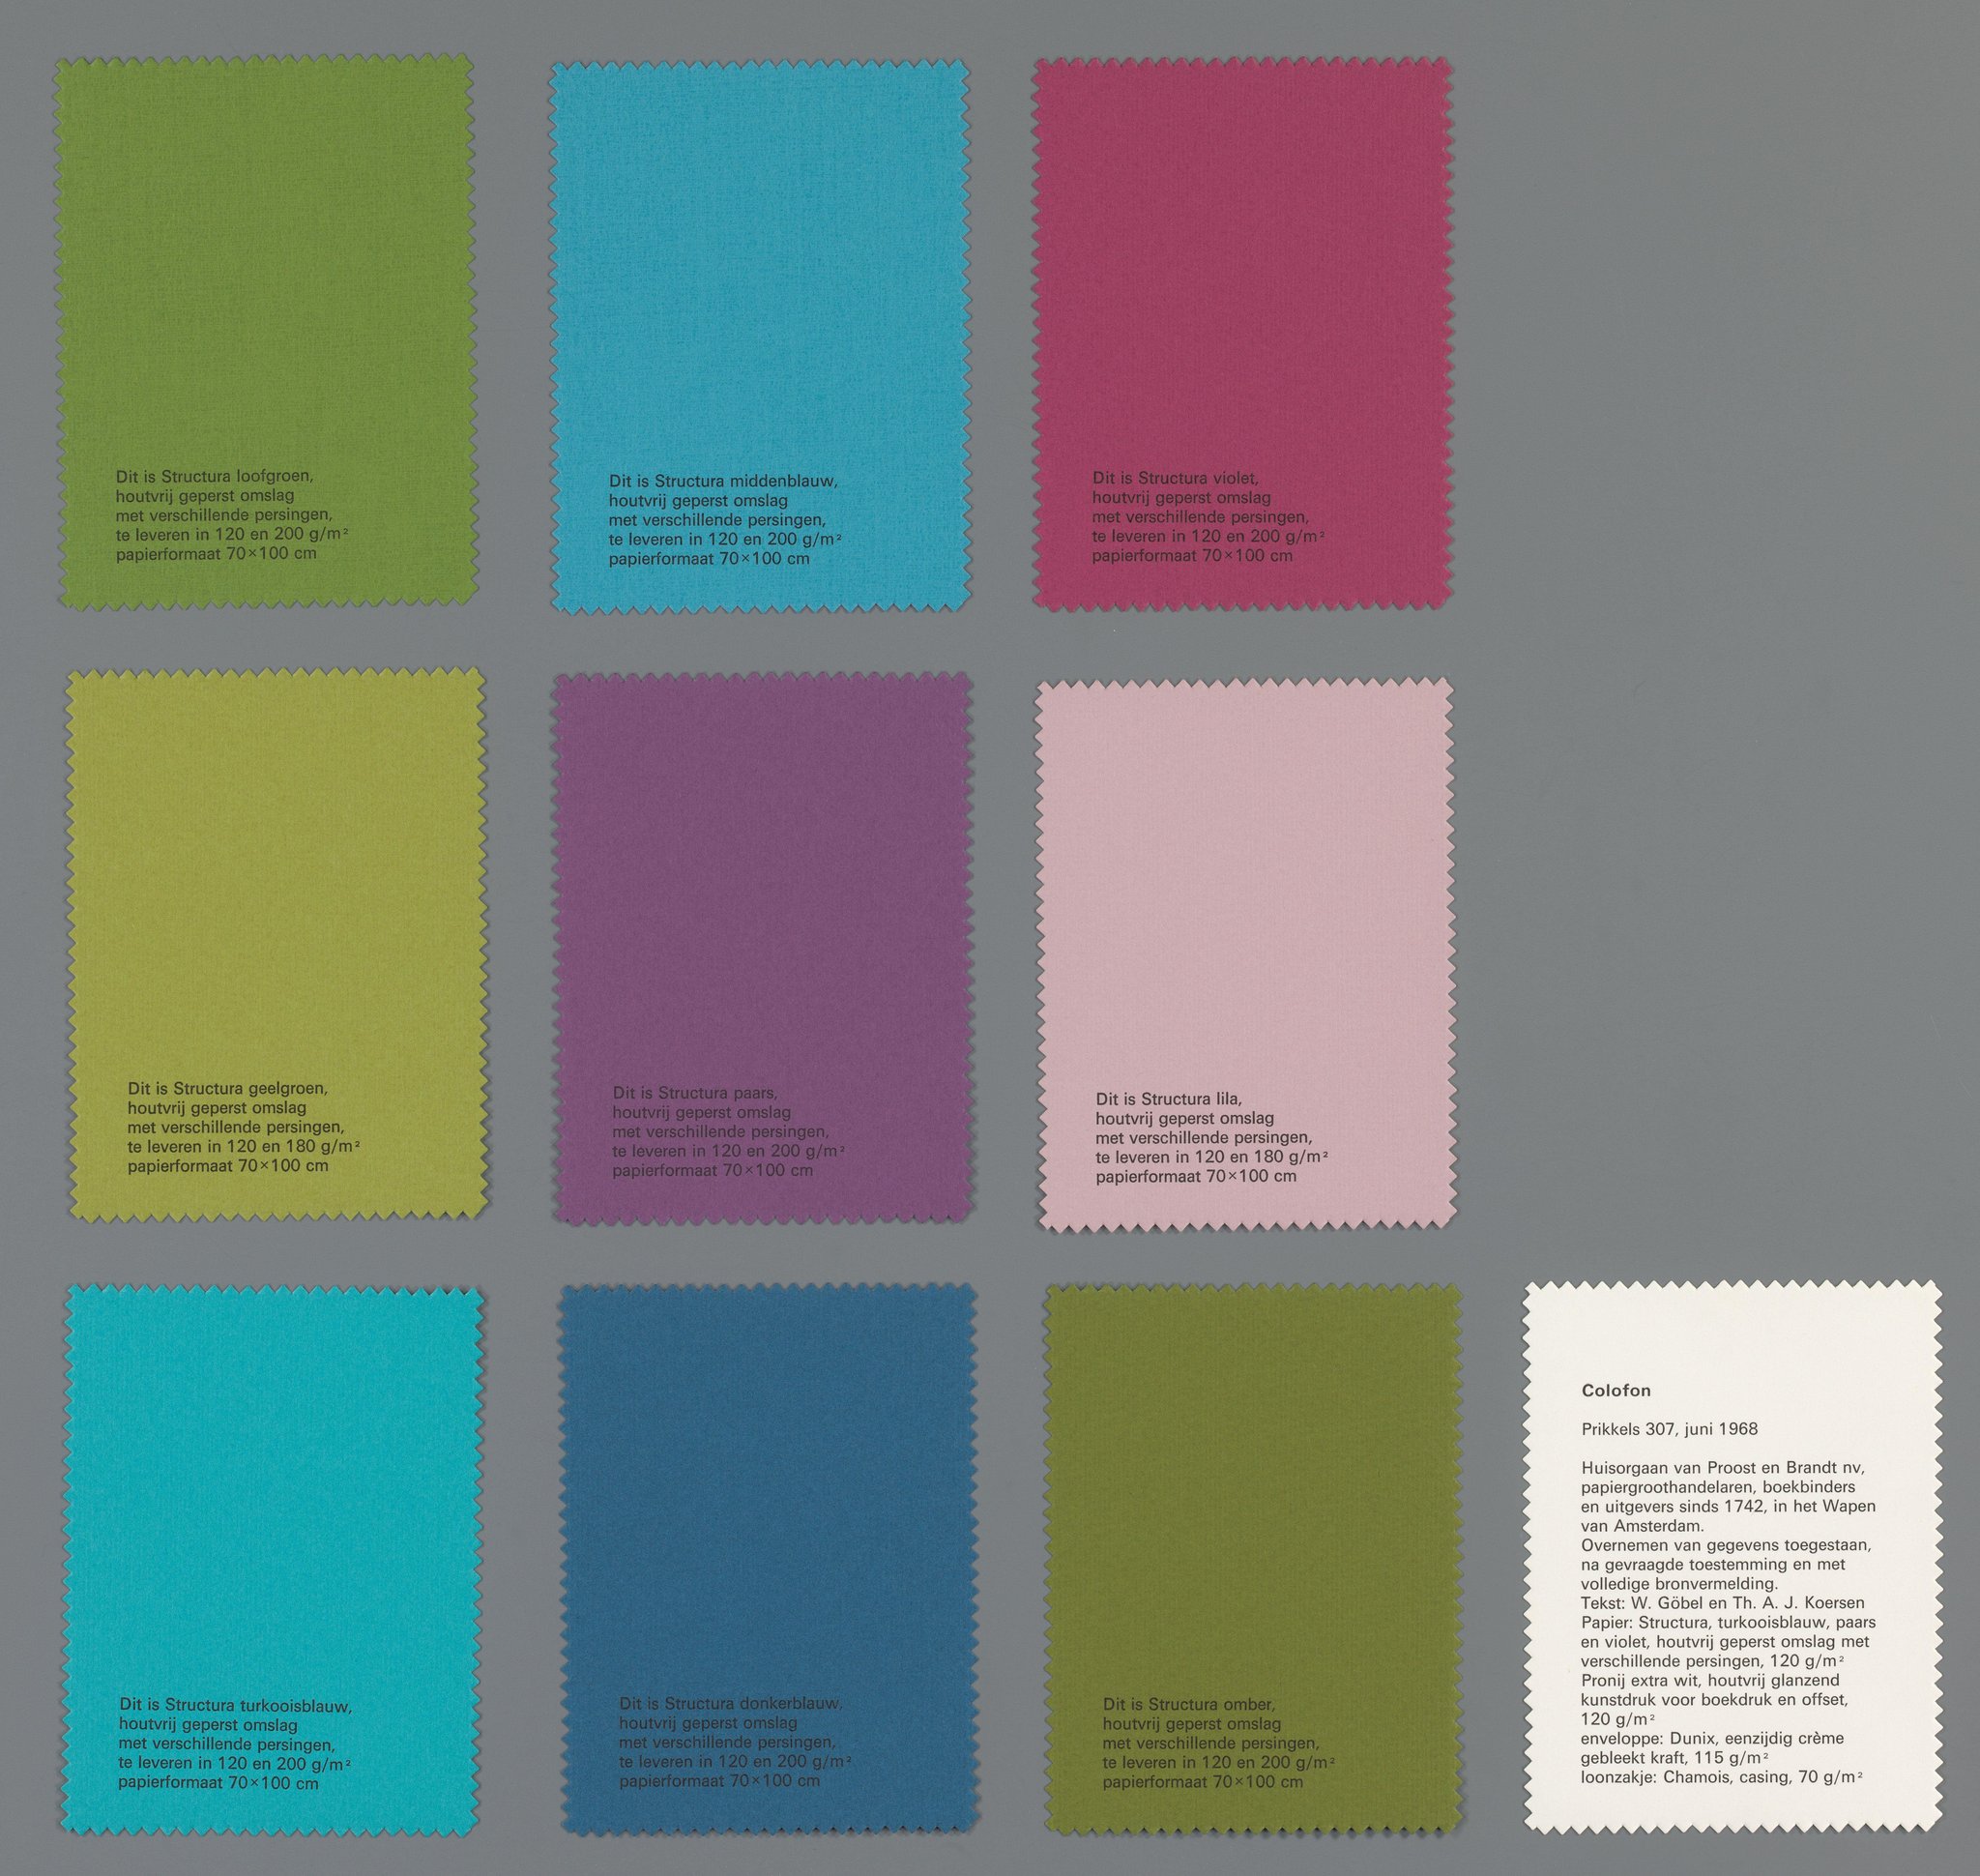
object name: reclamebiljet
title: Proost Prikkels 307, juni 1968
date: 1968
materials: paper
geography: netherlands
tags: advertising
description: Prikkels 307, juni 1968. Huisorgaan van Proost en Brandt NV, papiergroothandelaren, boekbinders en uitgevers. Negen losse bladen gekleurd papier en een wit blad Colofon, met gekartelde randen. In papieren 'loonzakje' met opschrift 'voor Papa'.